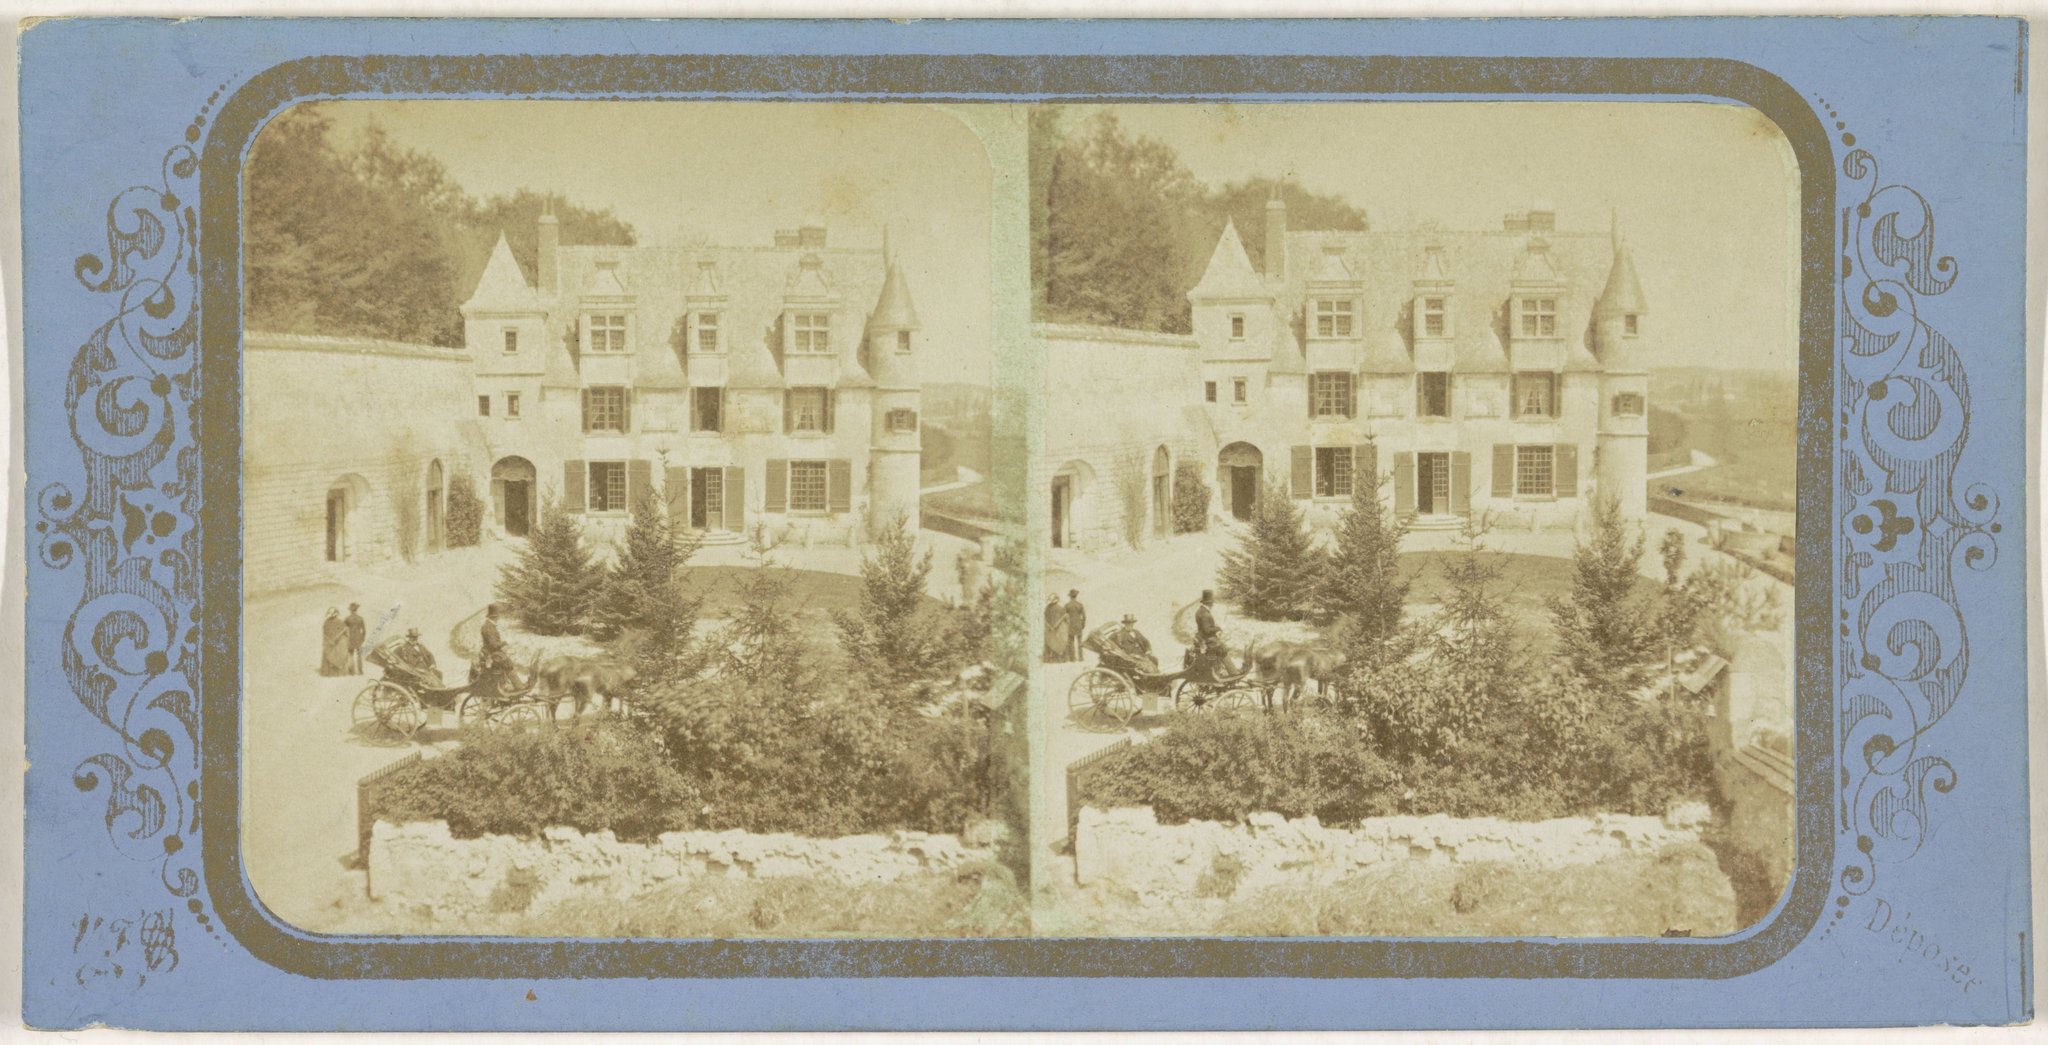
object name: stereograph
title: Gezicht op kasteel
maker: Anonymous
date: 1856-1922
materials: cardboard, paper, photographic support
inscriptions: label: ‘85 Le Retour au Château.’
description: Kasteel met op de voorgrond een koets getrokken door paarden.